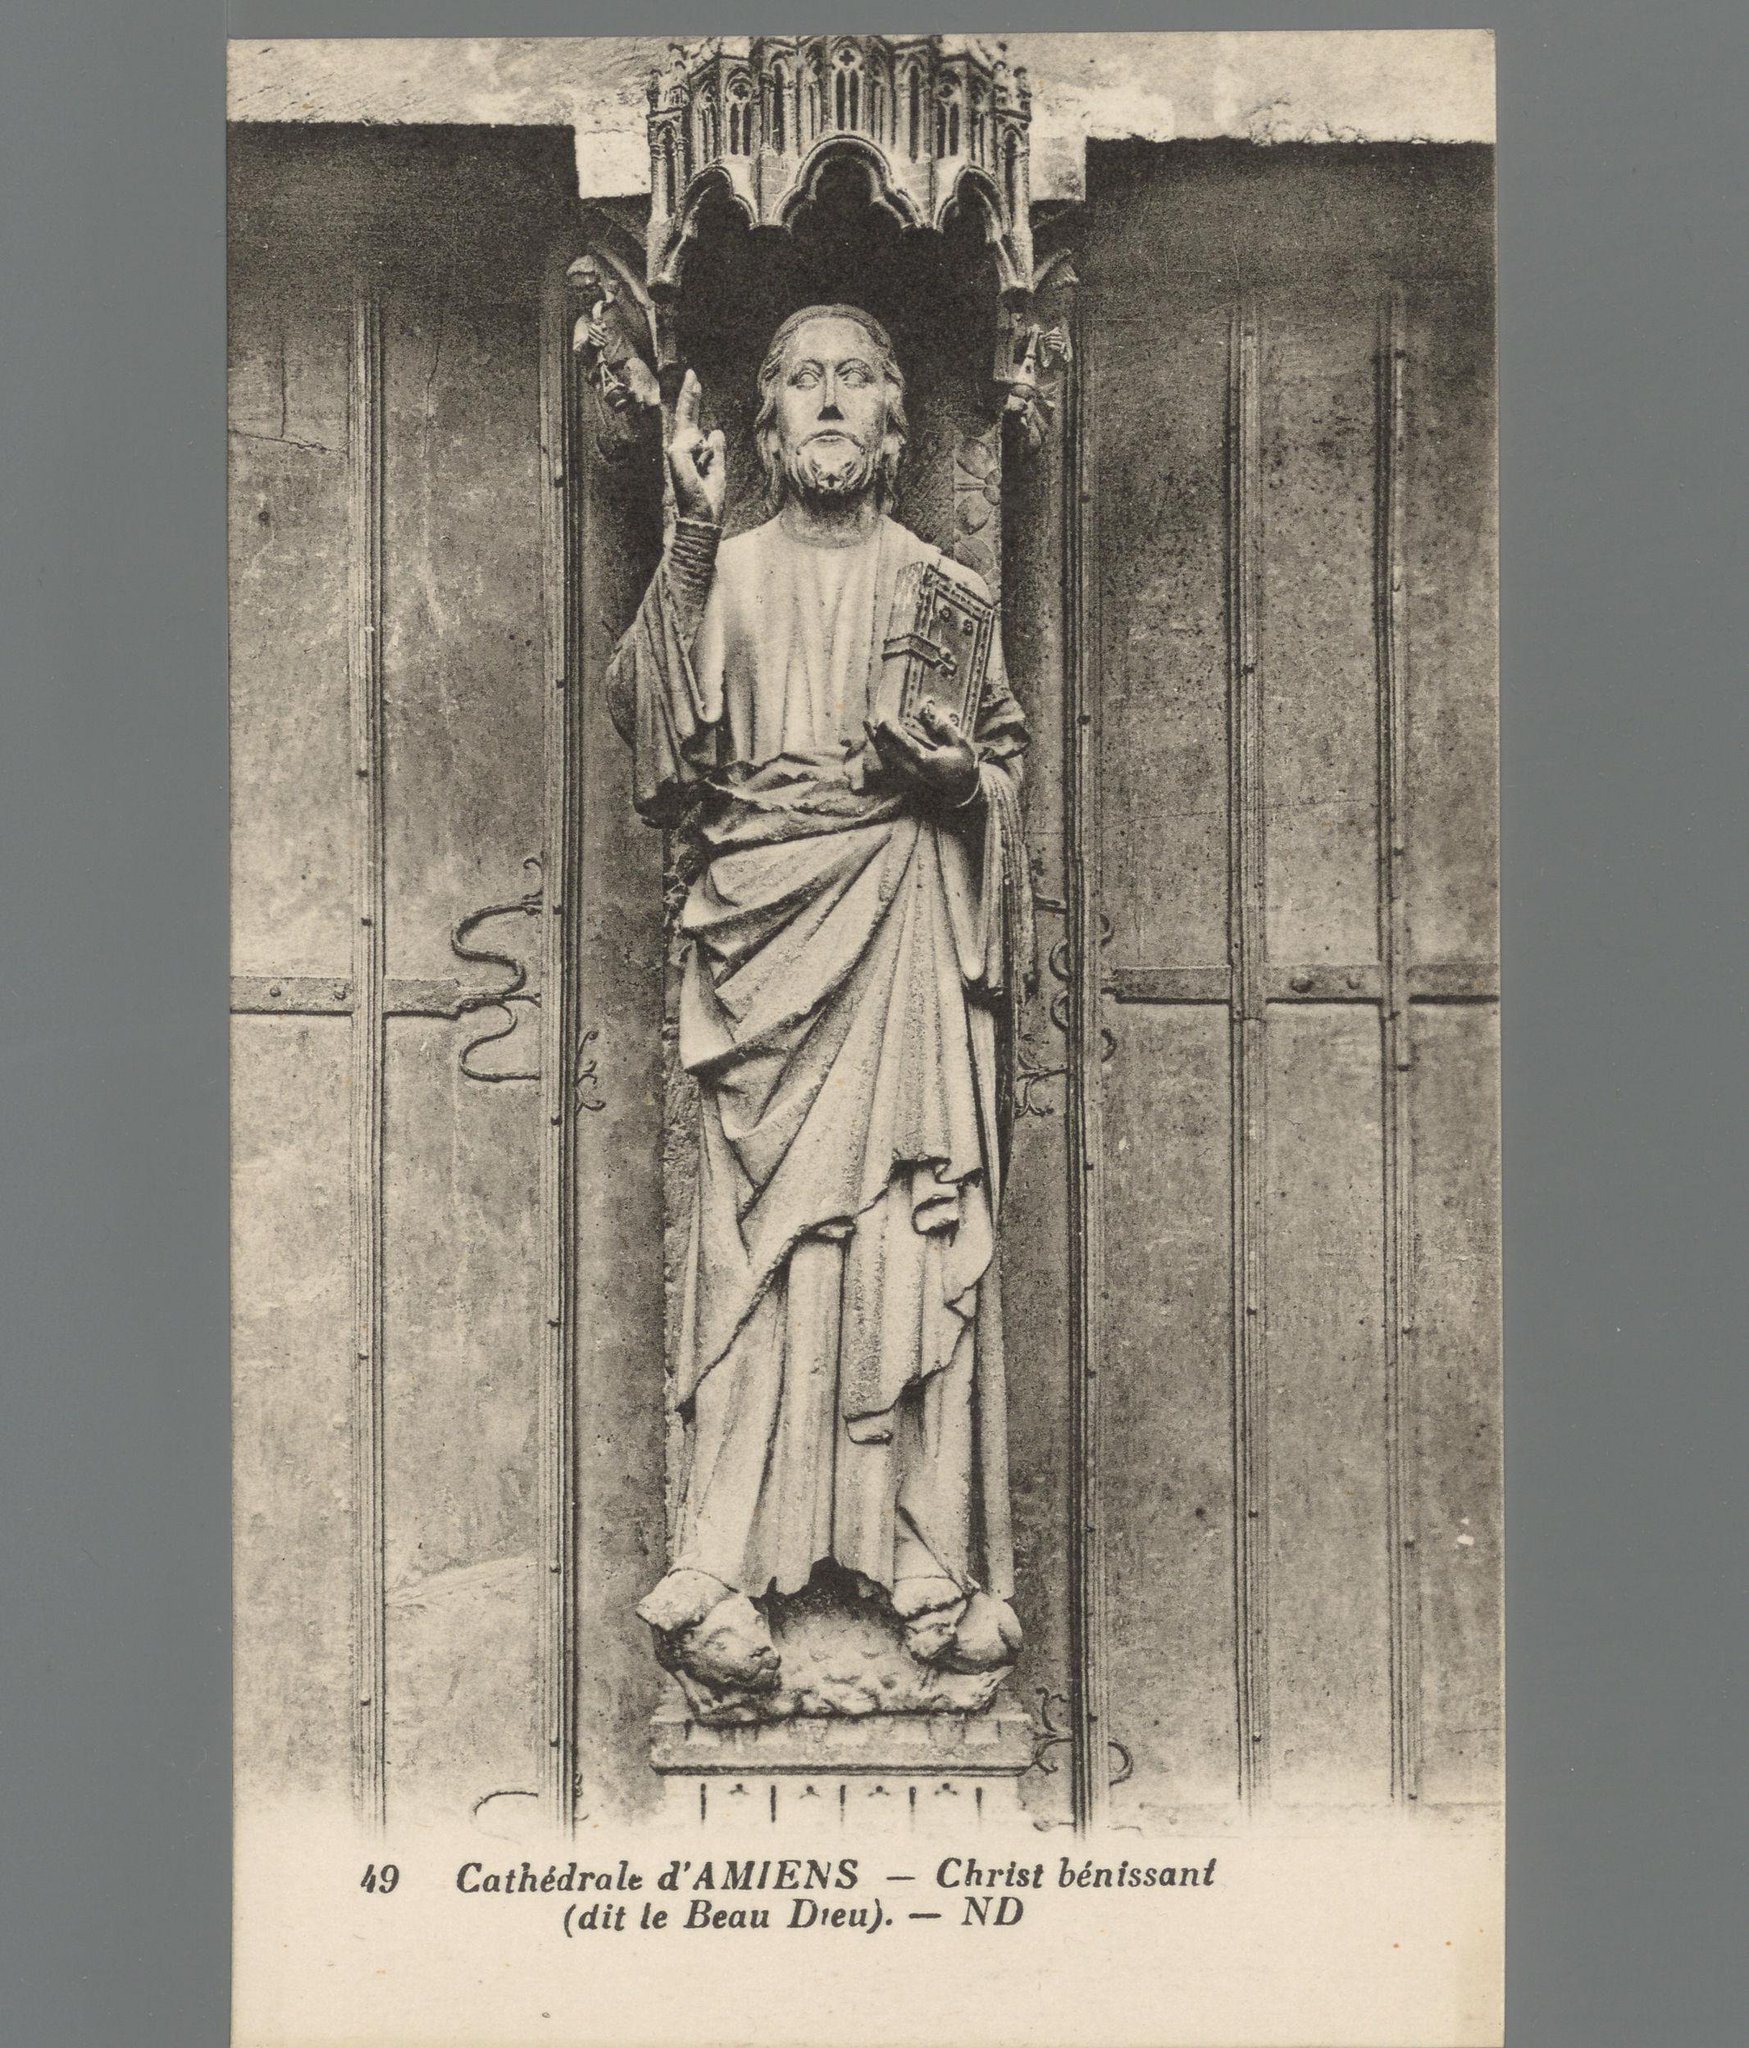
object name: photomechanical print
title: Cathédrale d'Amiens - Christ bénissant (dit le Beau Dieu)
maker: Anonymous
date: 1903-1932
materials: cardboard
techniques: photograph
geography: paris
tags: church (exterior), statues, paintings, etc. ~ objects of worship in roman religion, notre-dame d'amiens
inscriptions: collector's mark: ‘AFE v S’